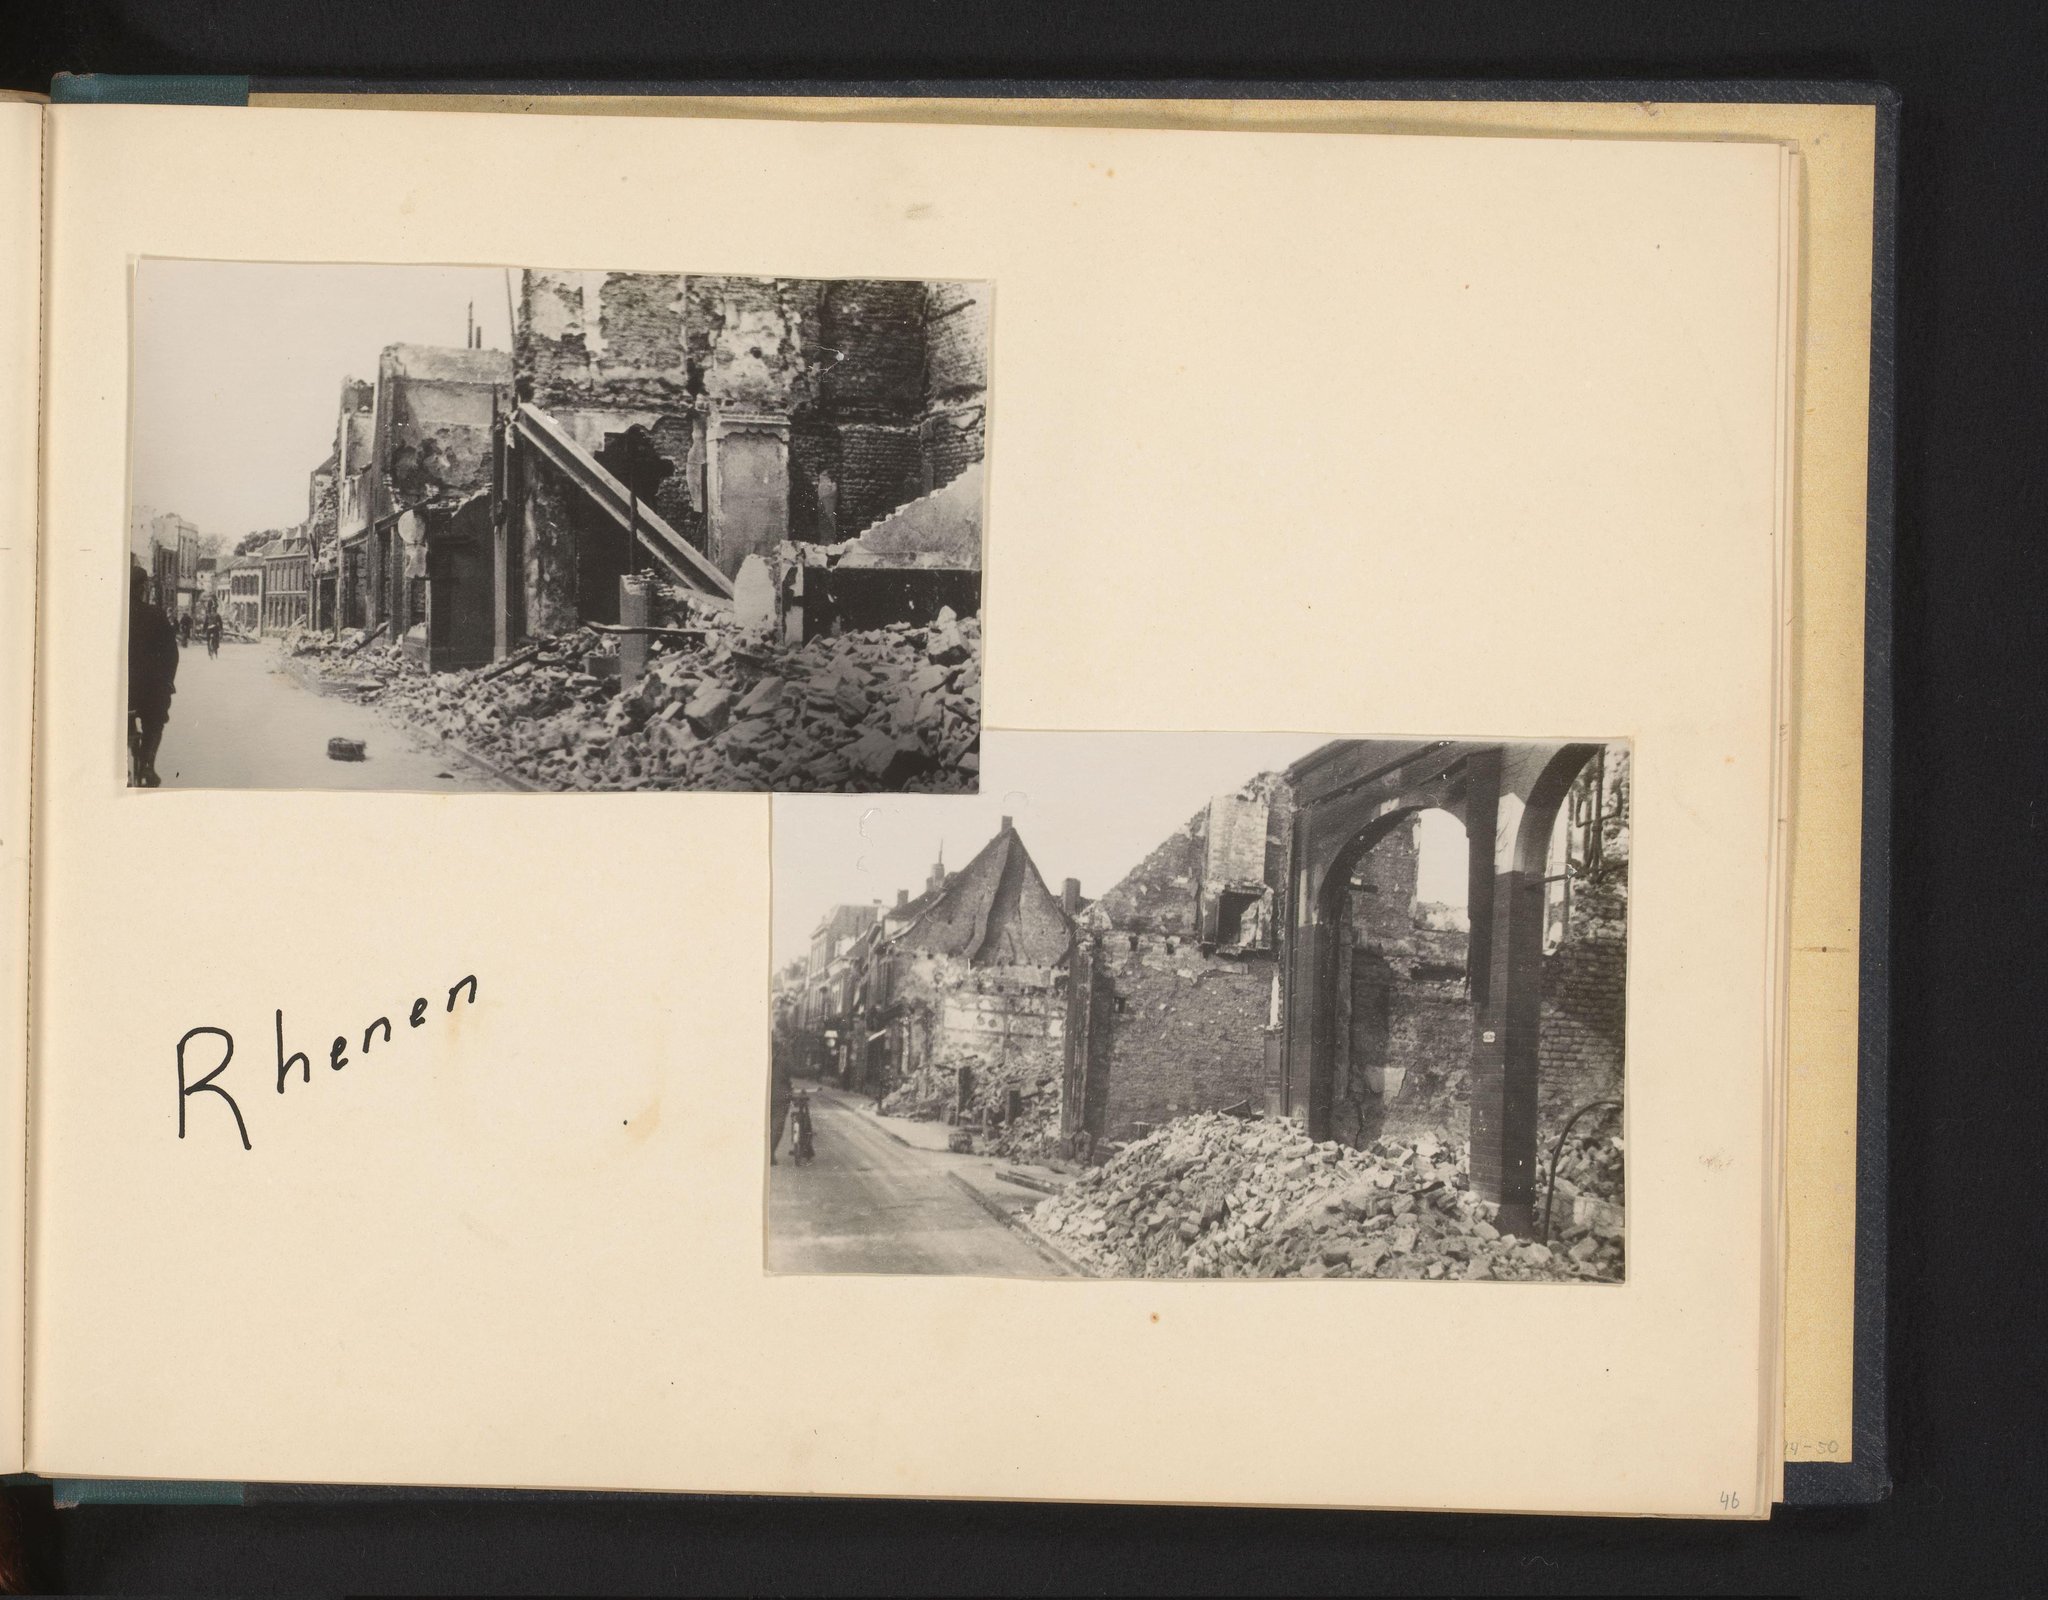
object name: photograph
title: Rhenen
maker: Anonymous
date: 1940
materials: cardboard, photographic support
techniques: gelatin silver print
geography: rhenen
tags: devastated, ruined place or city (~ warfare), rhenen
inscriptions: inscription: ‘Rhenen’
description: Albumblad met twee foto's van verwoeste gebouwen in Rhenen, na de Duitse inval in mei 1940. Onderdeel van het fotoalbum over de verwoestingen van Nederlandse steden en infrastructuur in het begin van de Tweede Wereldoorlog.